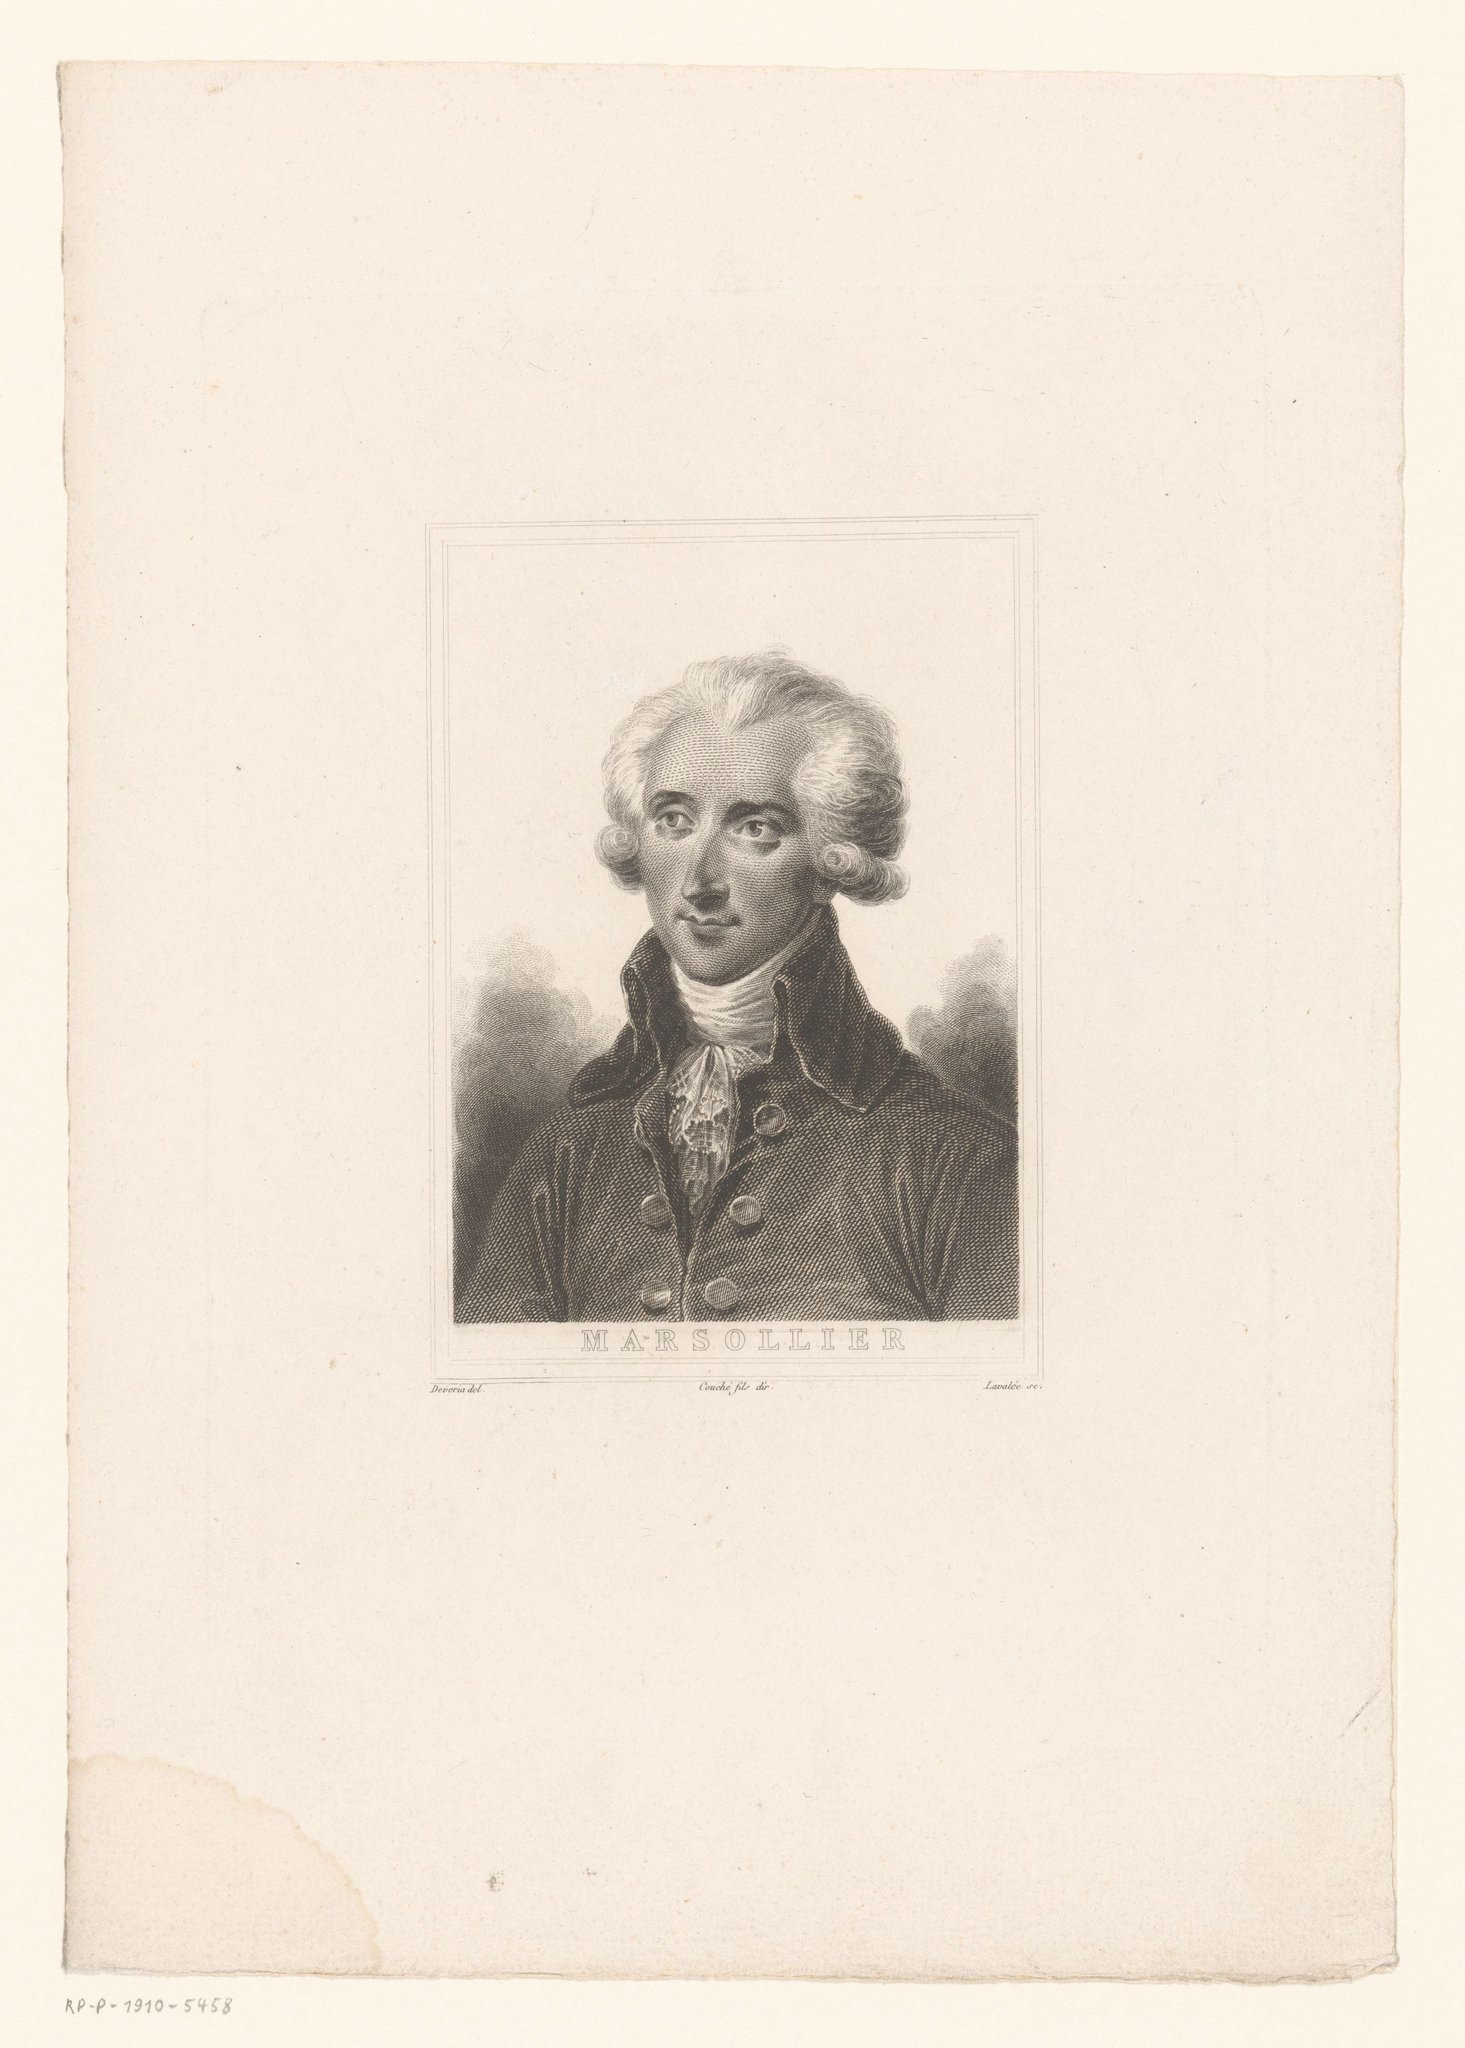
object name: print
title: Portret van Benoît-Joseph Marsollier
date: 1792-1830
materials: paper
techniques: etching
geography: france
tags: historical persons, portrait of a writer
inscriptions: collector's mark: Lugt 2228